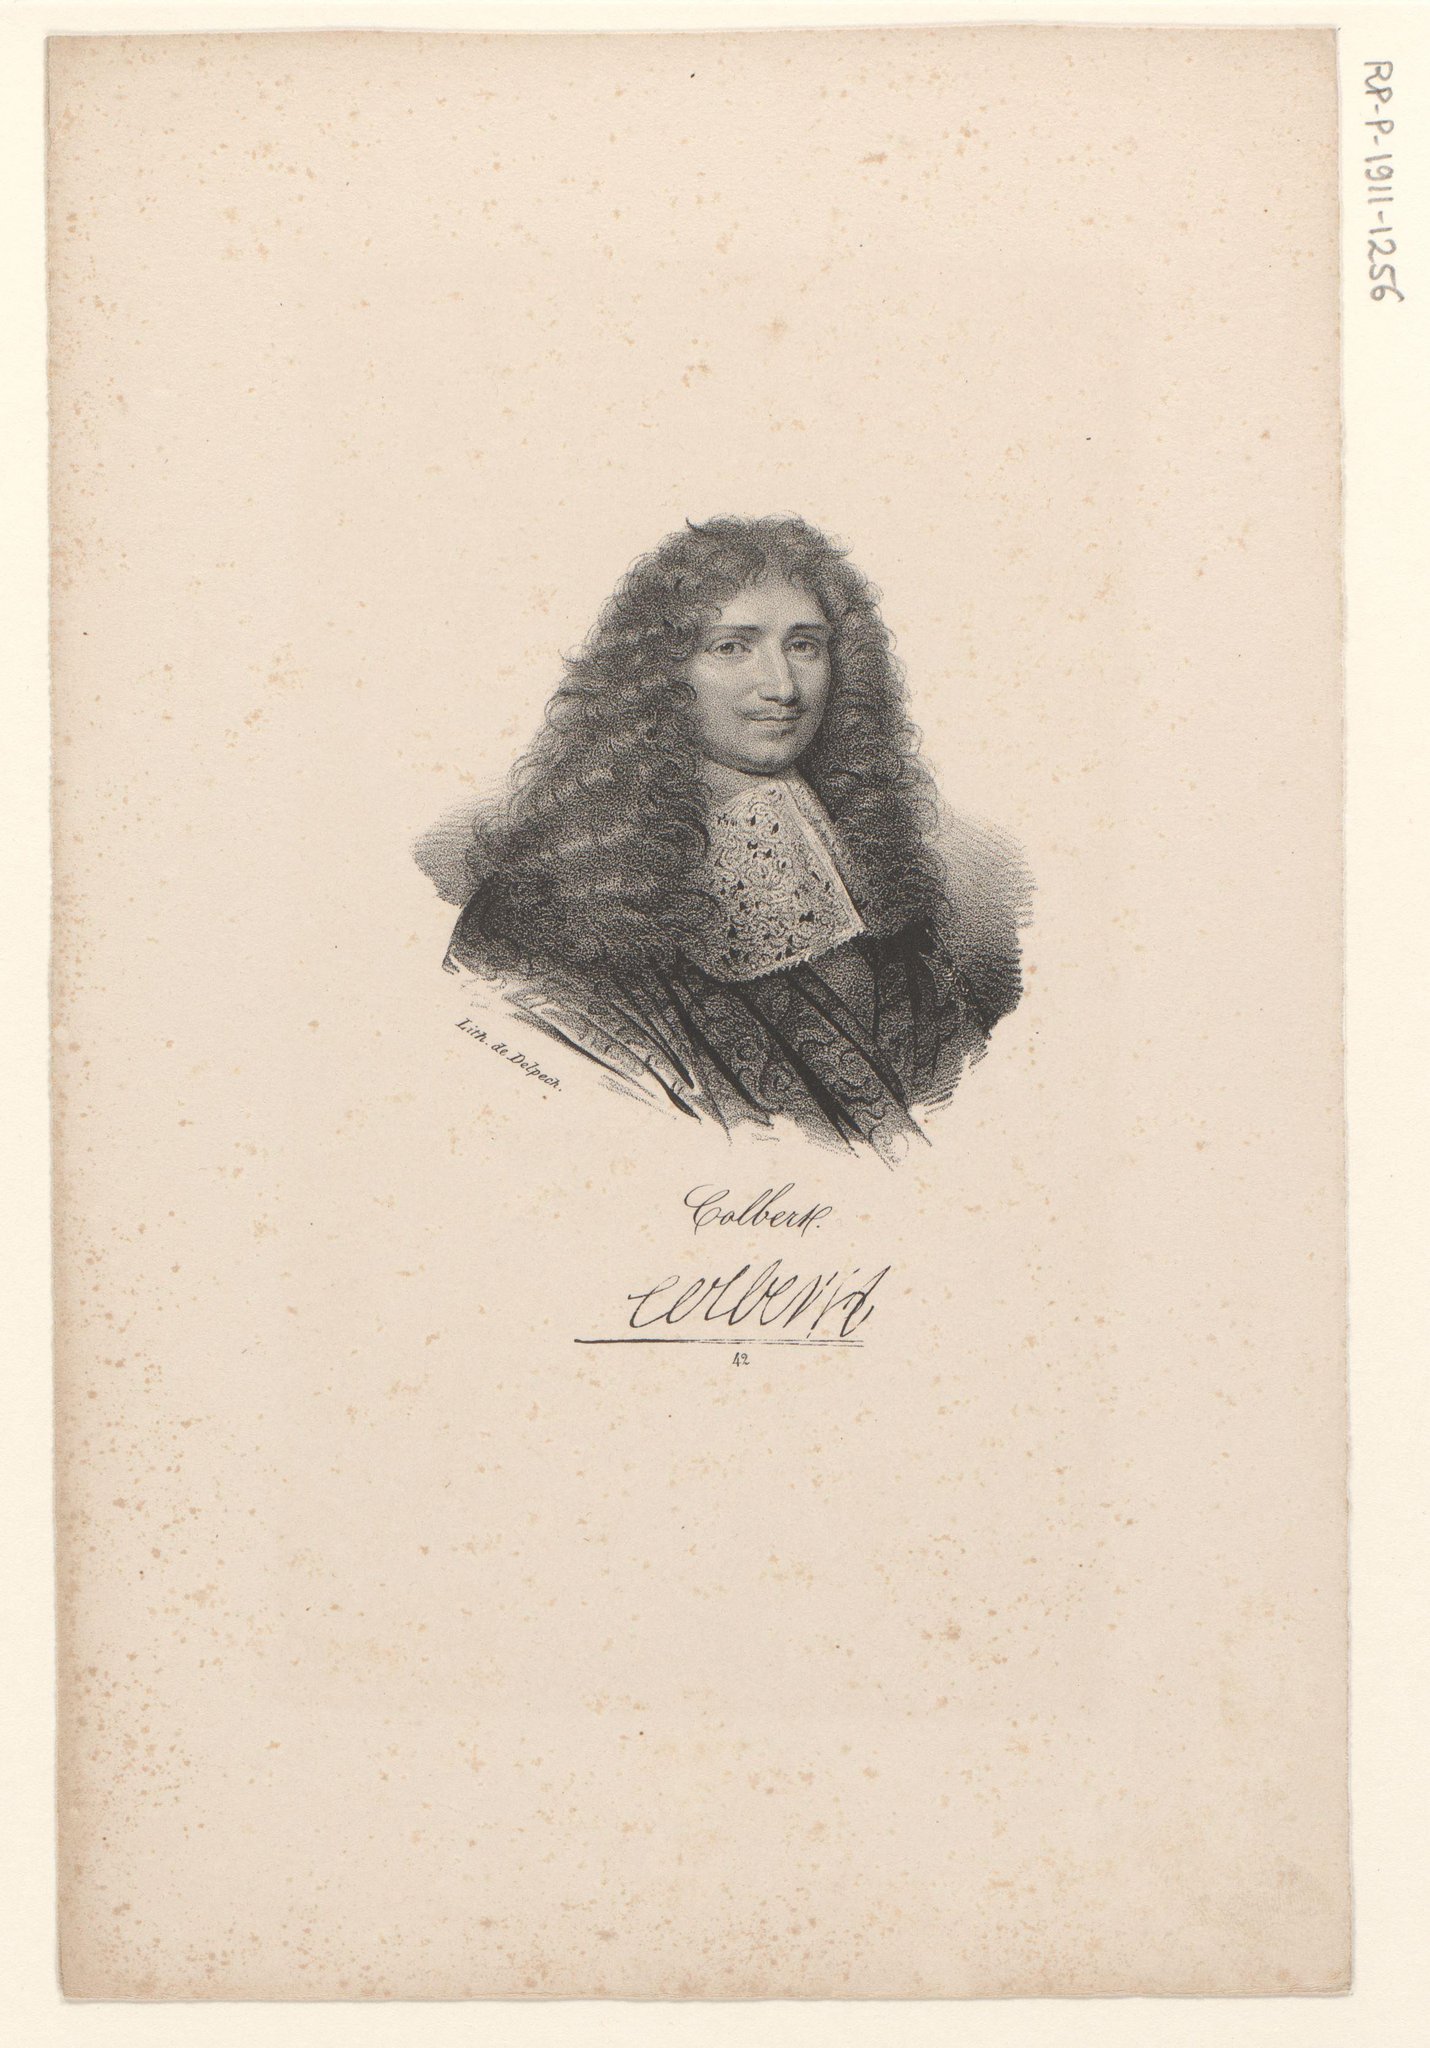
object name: print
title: Portret van Jean-Baptiste Colbert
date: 1818-1842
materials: paper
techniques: lithograph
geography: paris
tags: jean-baptiste colbert, historical persons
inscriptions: collector's mark: Lugt 2228a